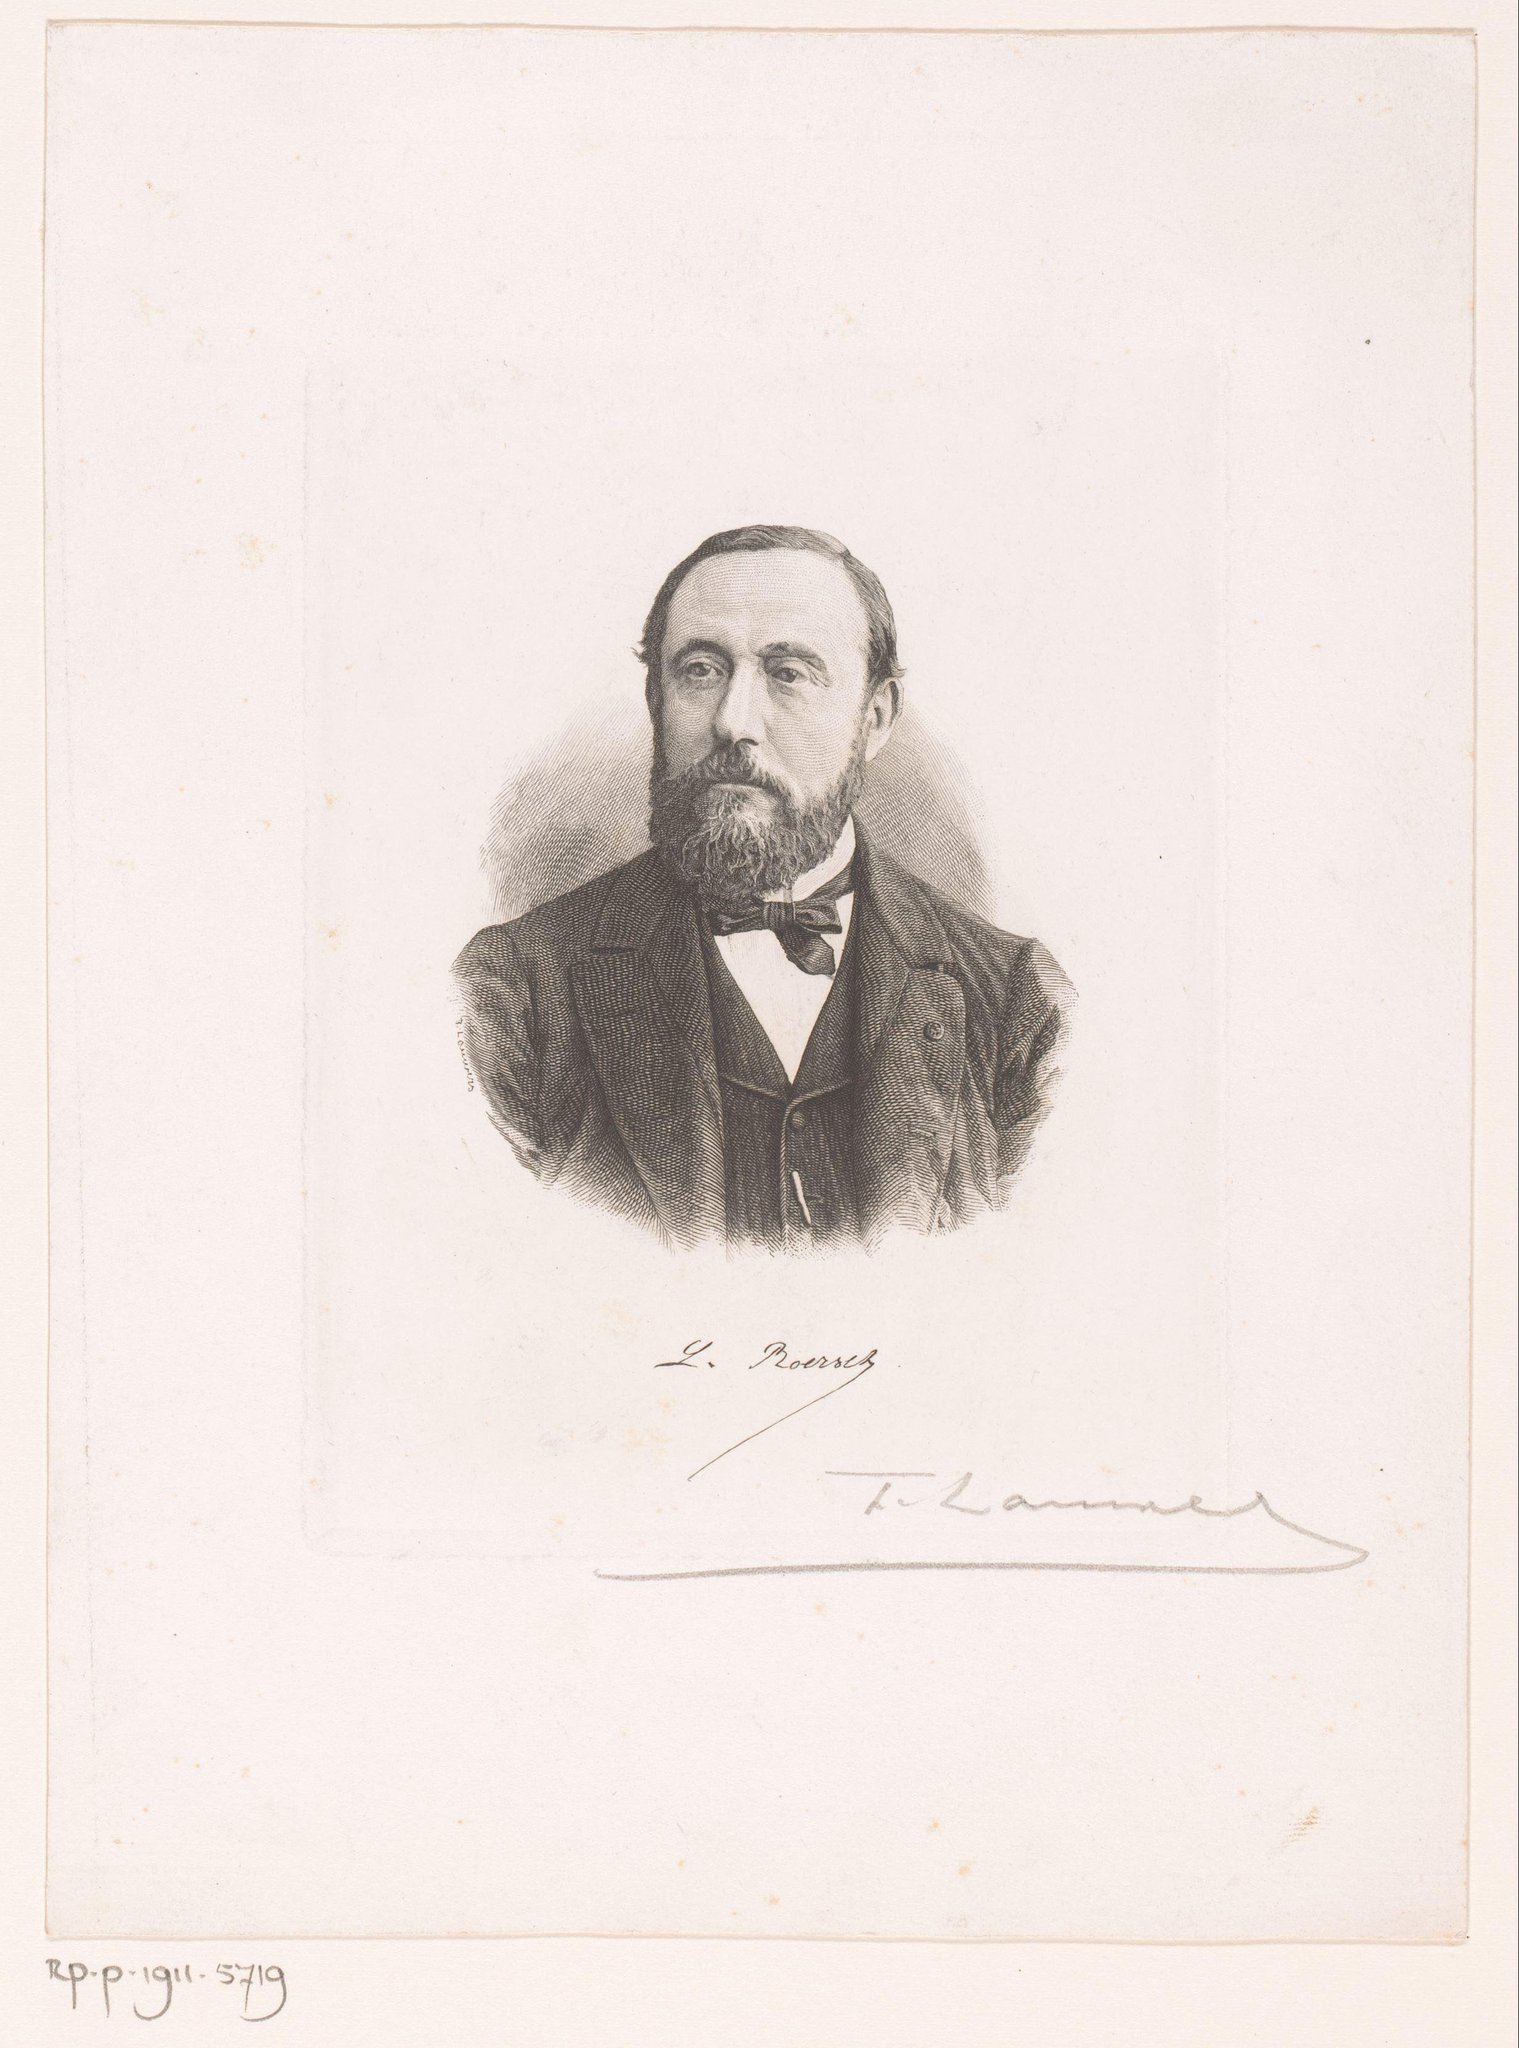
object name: print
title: L. Roersch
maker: frans lauwers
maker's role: print maker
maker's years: 1854-1931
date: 1864-1911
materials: paper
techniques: etching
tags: maastricht, historical persons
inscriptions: collector's mark: Lugt 2228